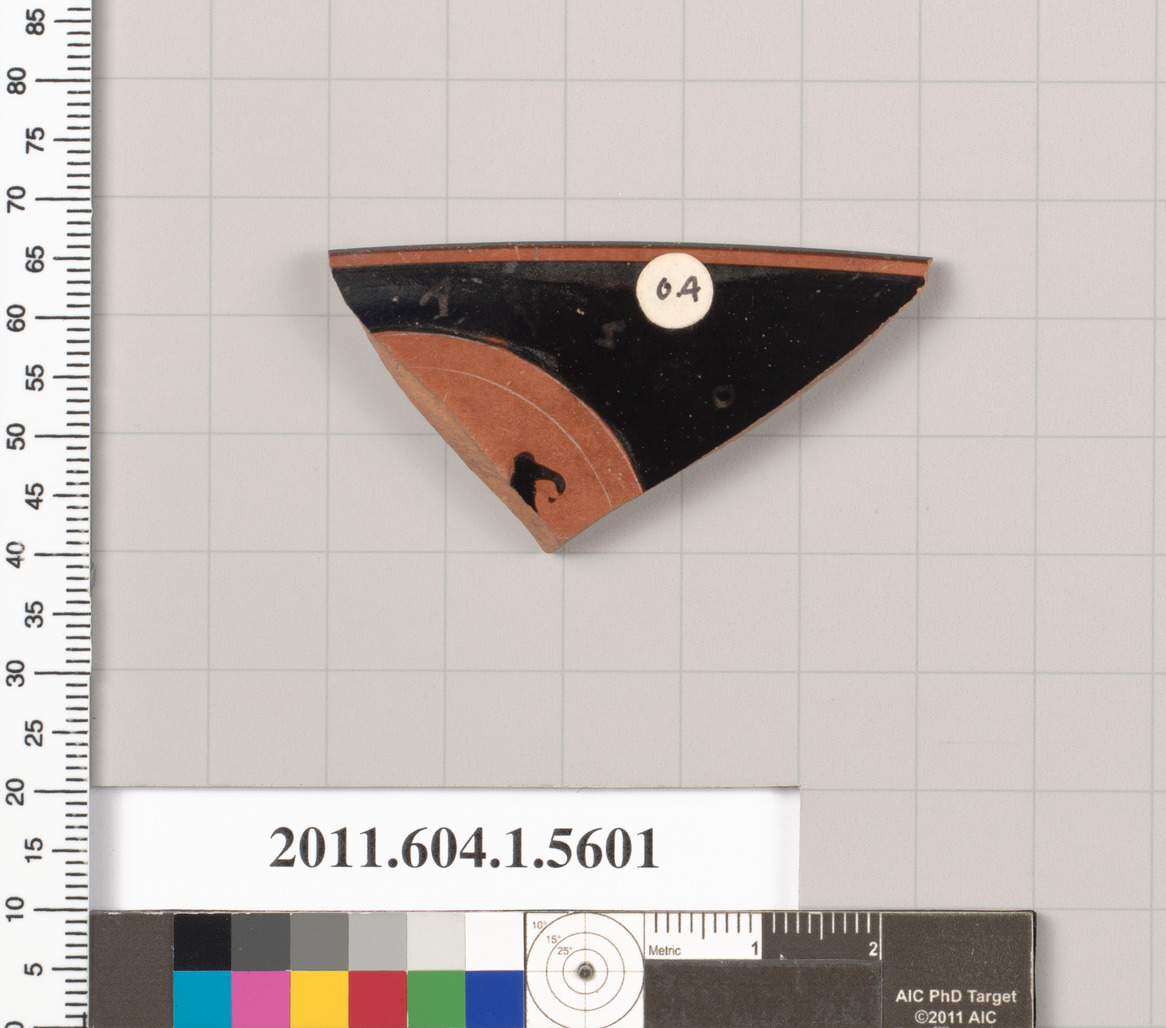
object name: kylix fragment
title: Terracotta rim fragment of a kylix (drinking cup)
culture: greek, attic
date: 520-490 BCE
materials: terracotta